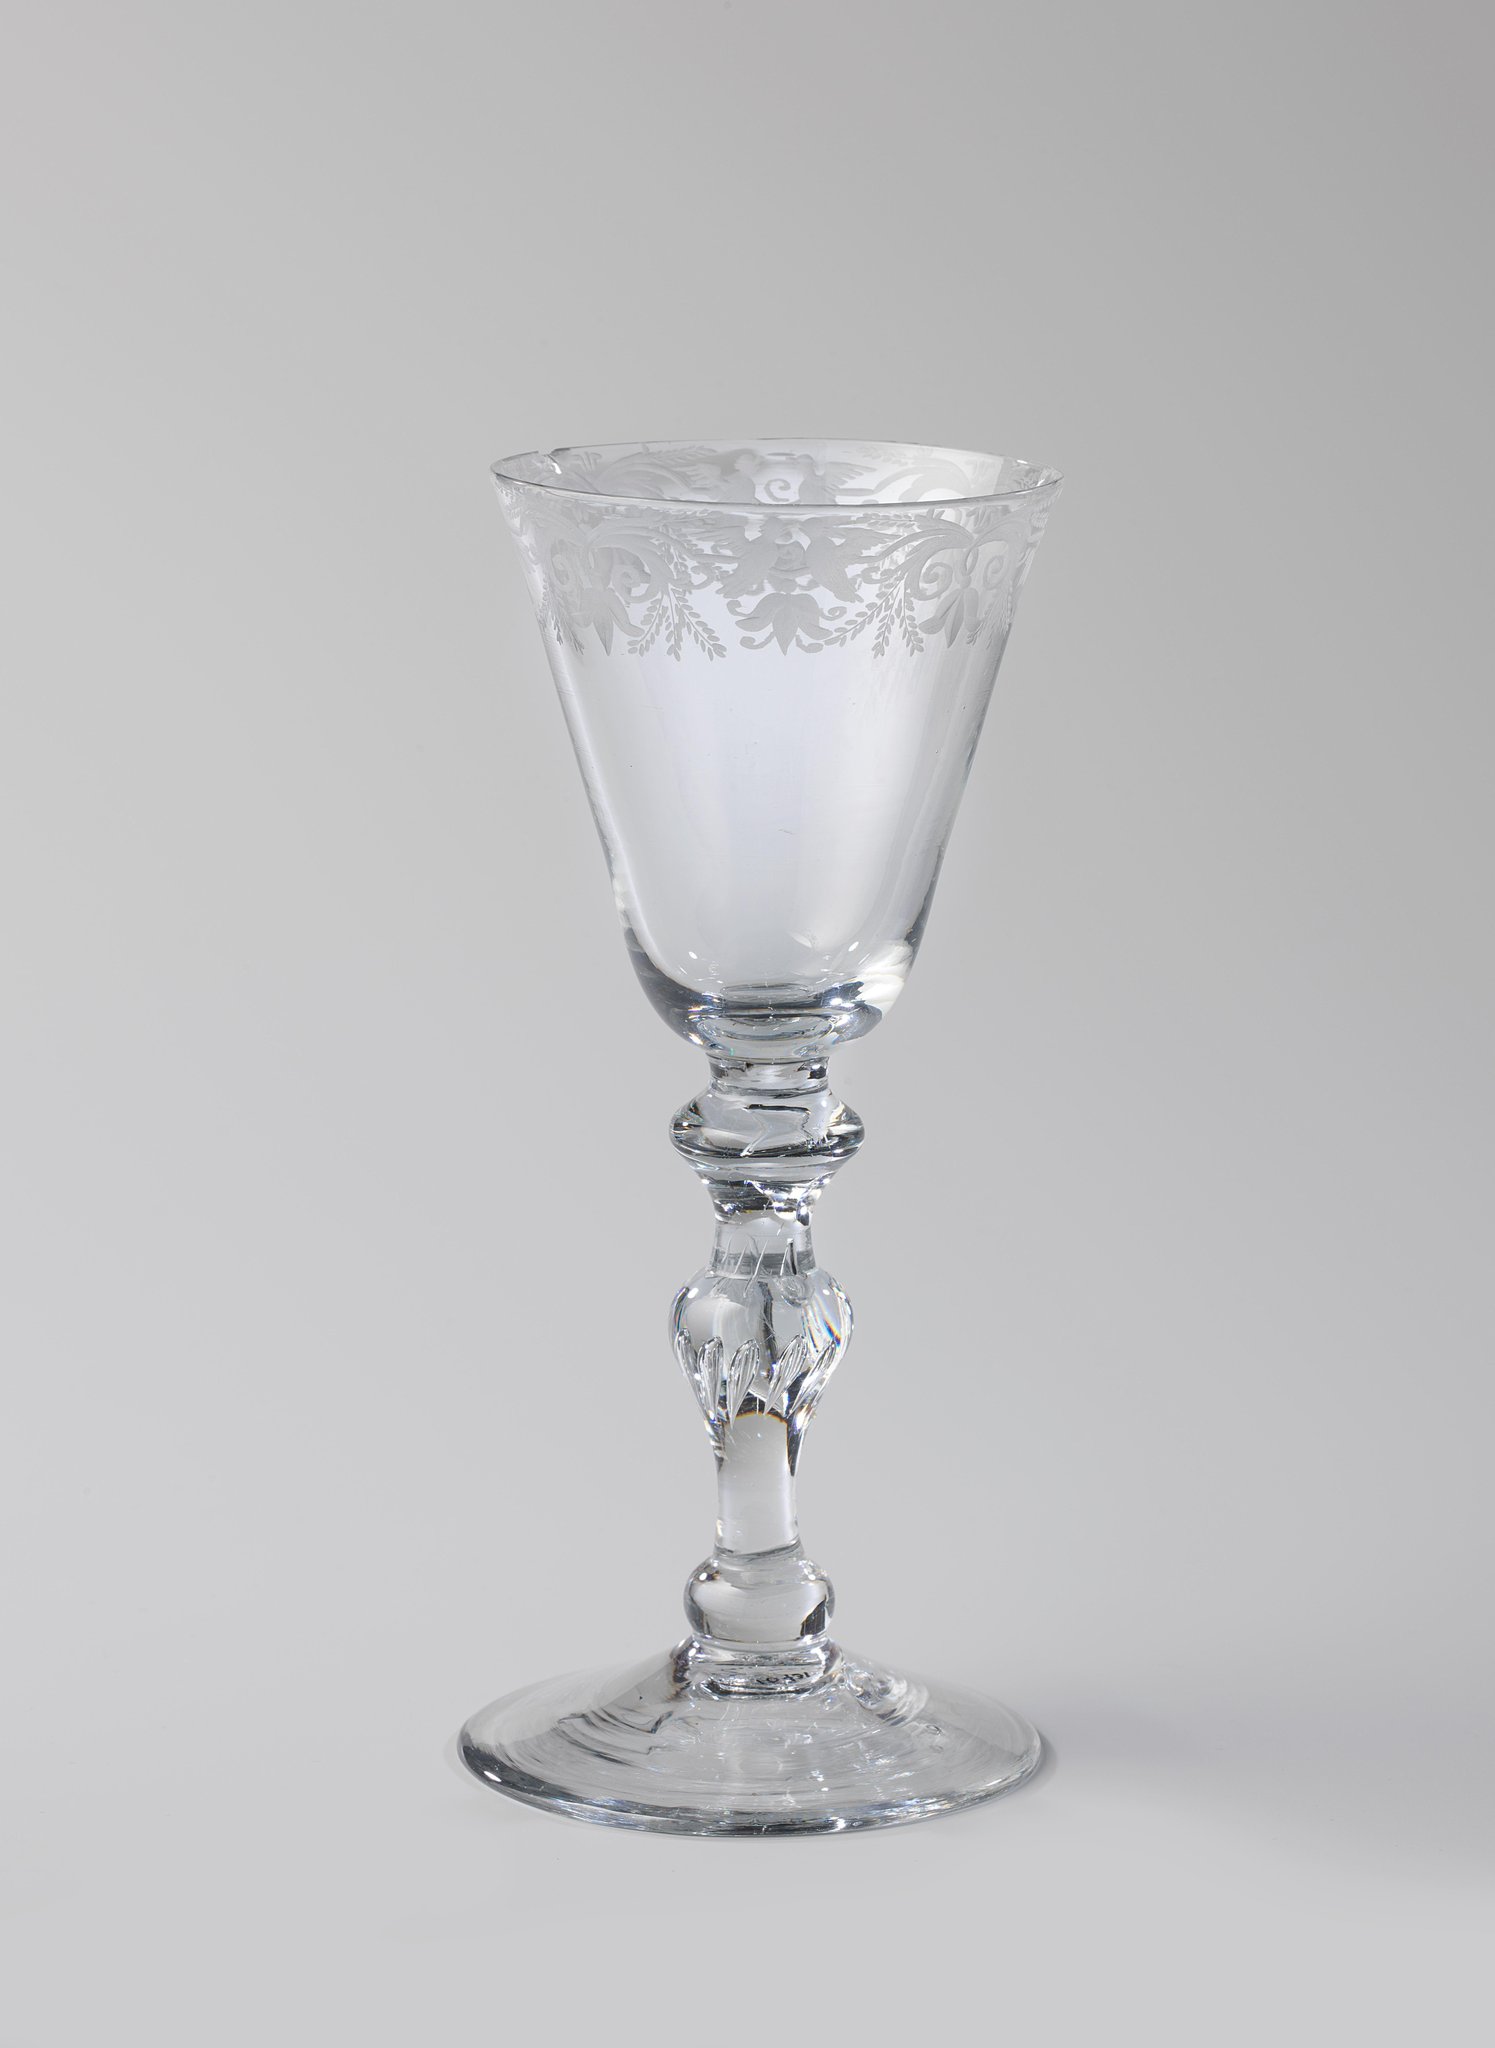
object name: goblet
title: Kelkglas met ornamentrand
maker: Anonymous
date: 1750-1775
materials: glass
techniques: glassblowing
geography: northern netherlands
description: Conische voet. Balustervormige stam met drie knopen met enkele luchtbellen. Trechtervormige kelk met afgeronde bodem. Op de kelk, langs de mondrand, een symmetrische ornamentrand met bandwerk, bladranken, klokjes en twee tortelduiven.